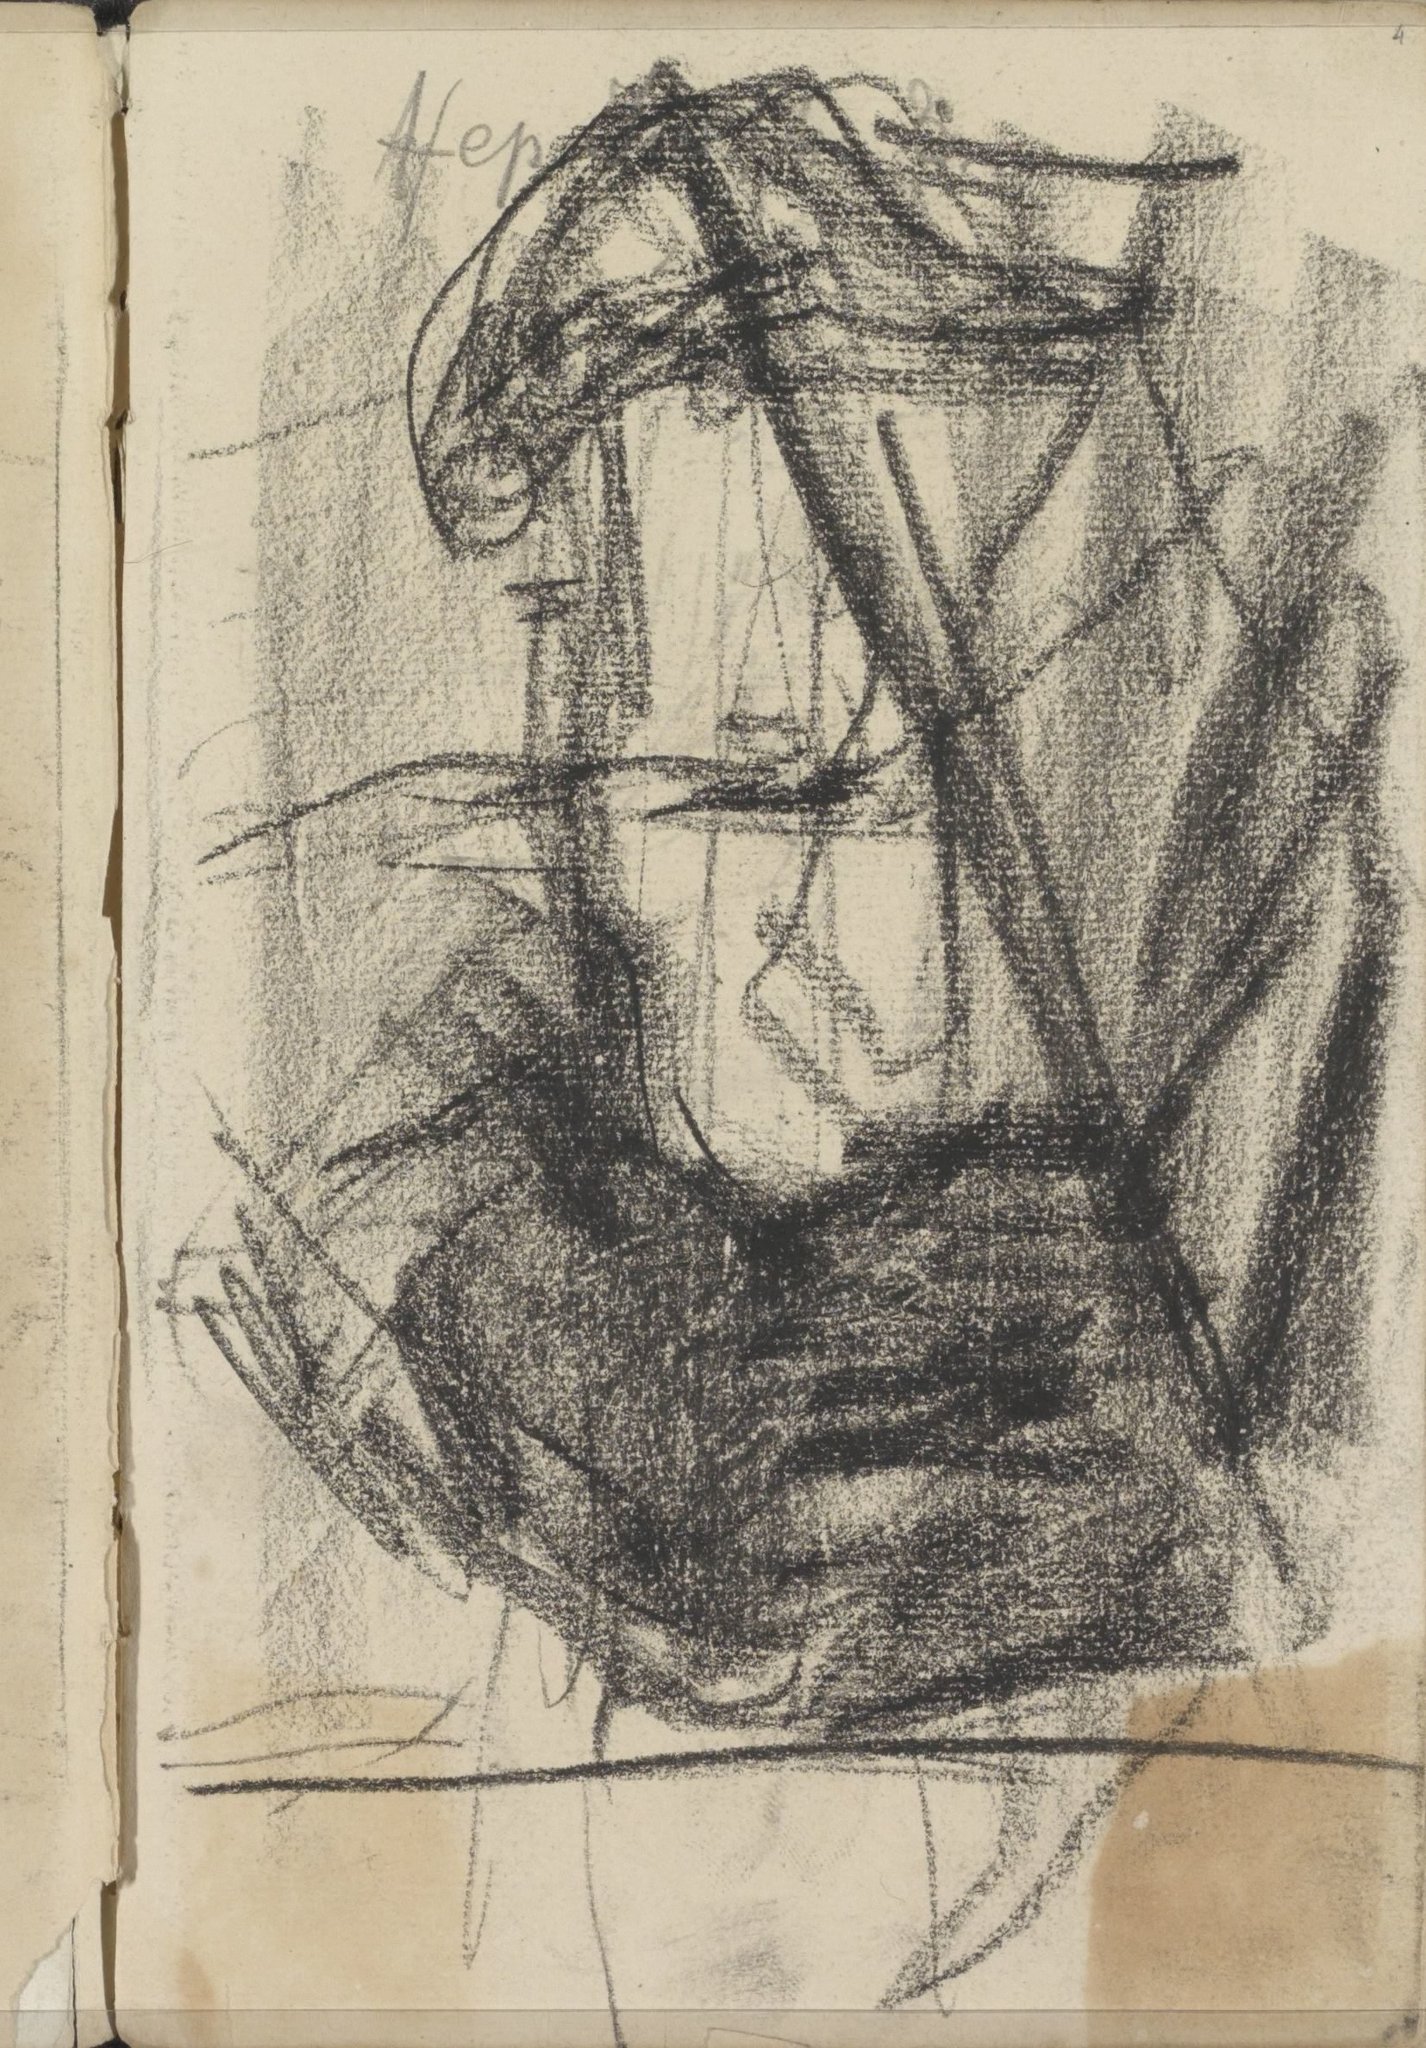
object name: sketchbook leaf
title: Bukkende figuren, mogelijk arbeiders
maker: george hendrik breitner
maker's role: draughtsman, painter, print maker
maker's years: 1857-1923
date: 1886-1923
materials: chalk, paper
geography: amsterdam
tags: bending figure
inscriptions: annotation: ‘[...]’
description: Pagina 4 uit een schetsboek met 17 bladen.